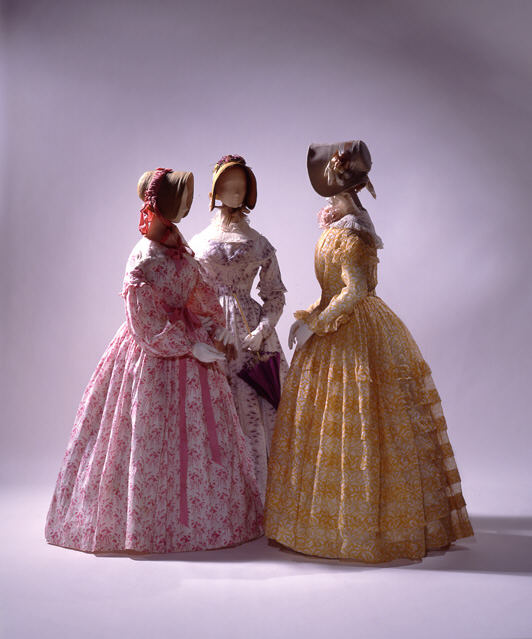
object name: morning dress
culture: british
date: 1837-1840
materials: cotton